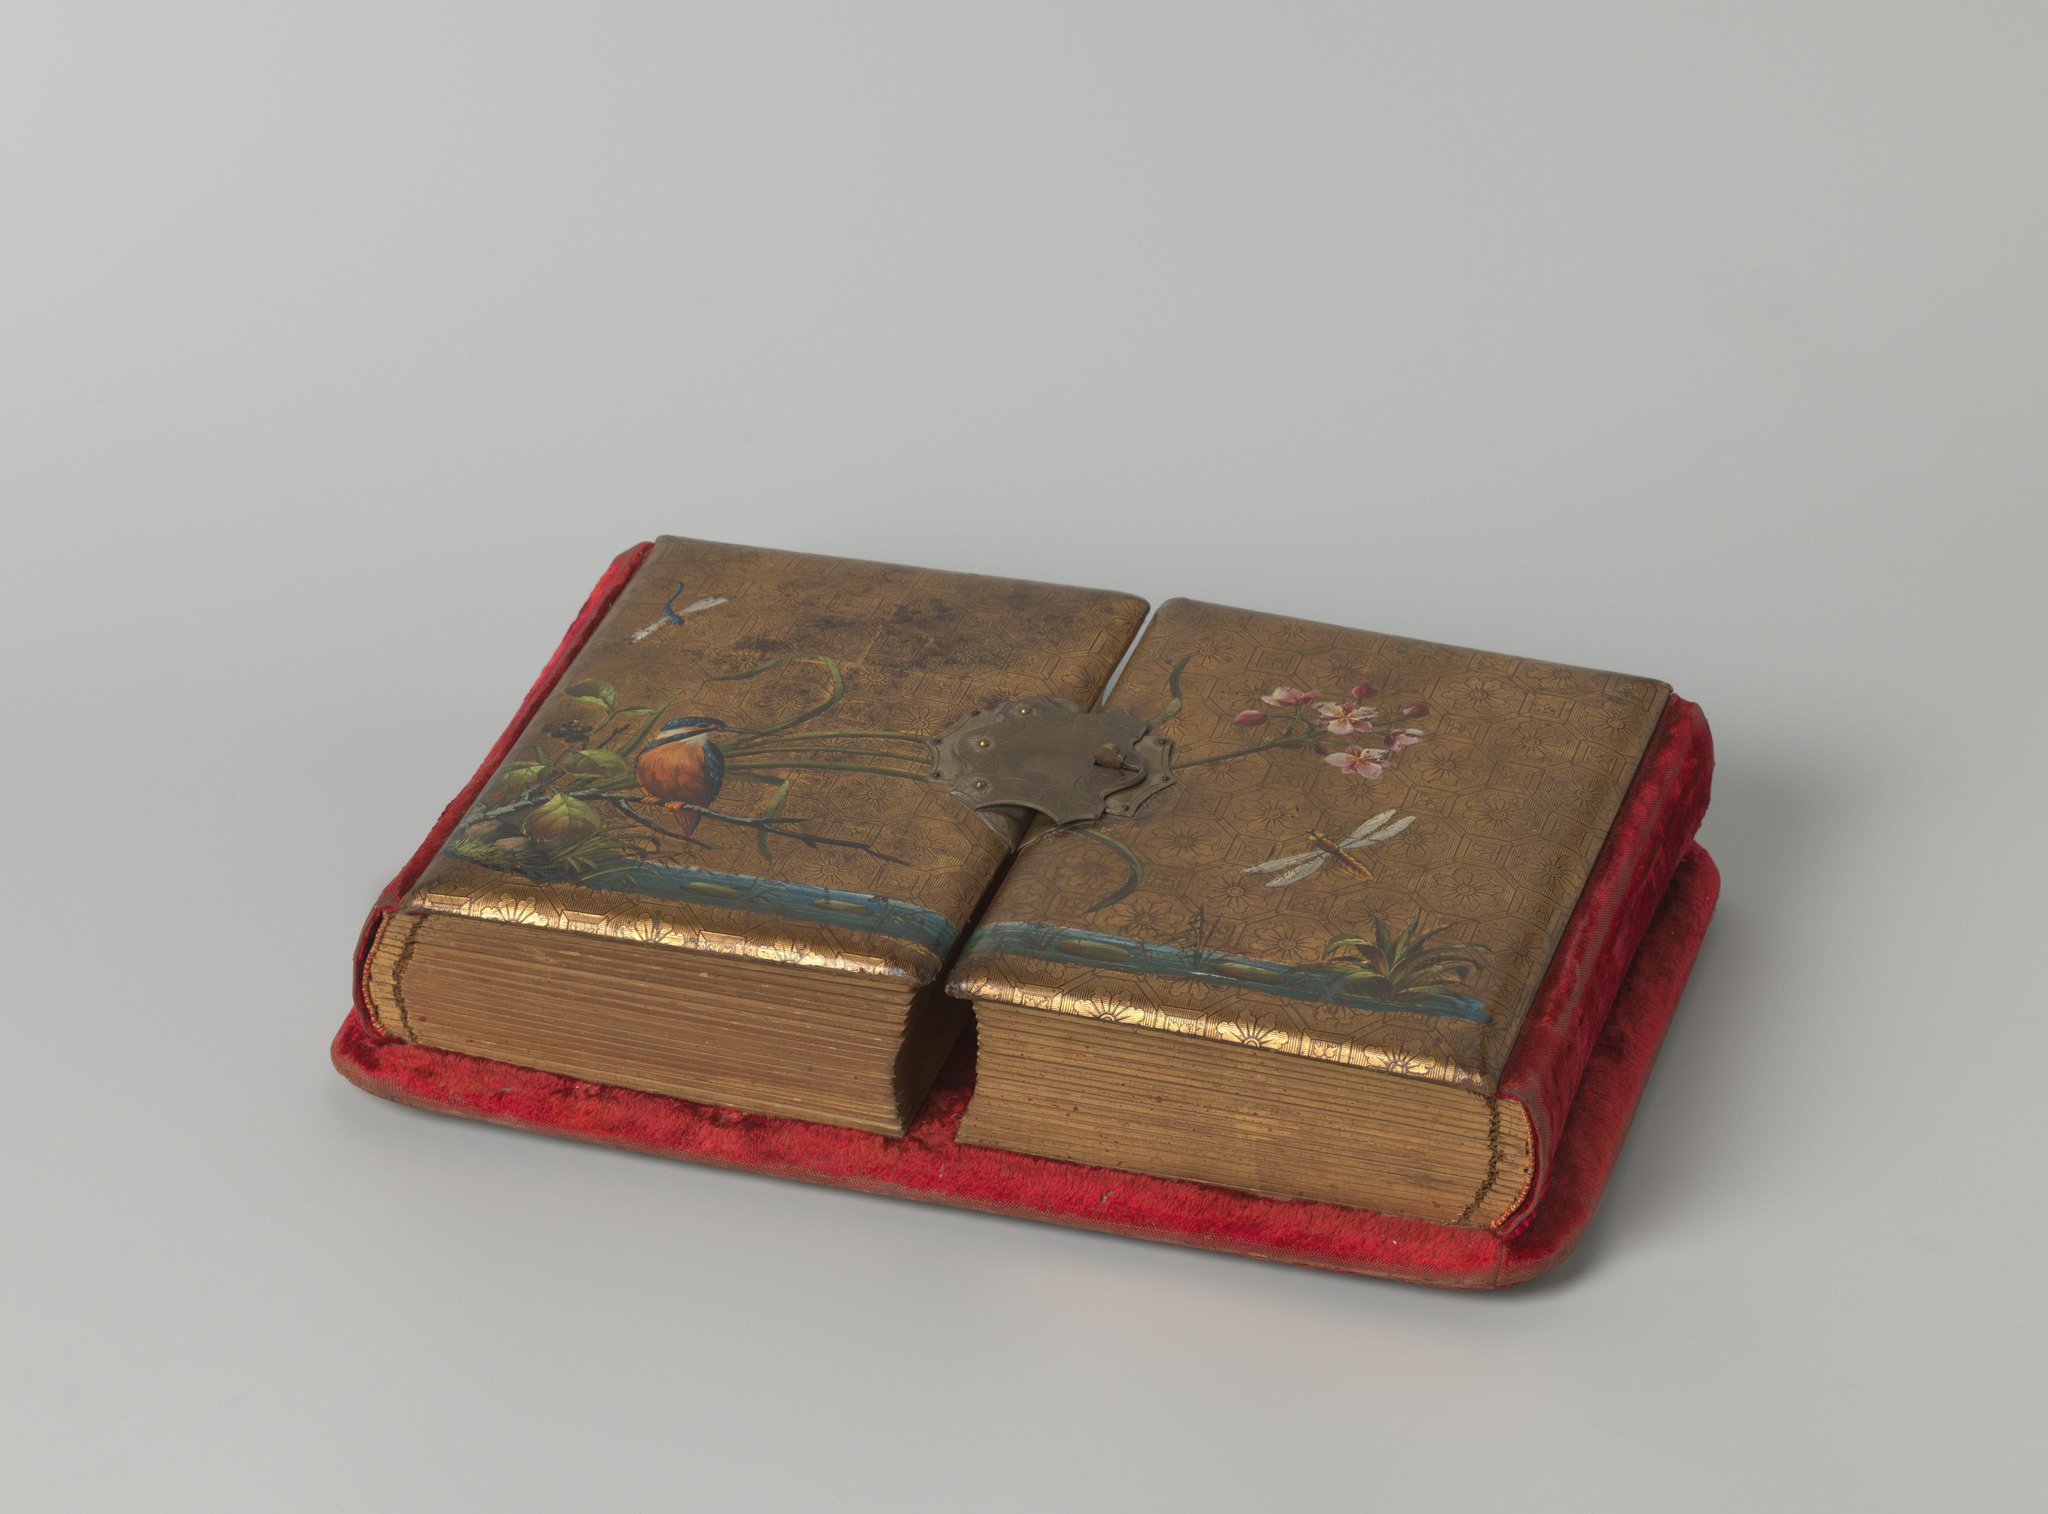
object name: slip in album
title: Portretten van artiesten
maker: Anonymous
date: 1860-1900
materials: cardboard, paint, leather, metal, photographic support, velvet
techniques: albumen print, brush, decorated paper, hand coloring, platinum process, woodburytype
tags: adult man, historical persons, portrait of actor, actress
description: Fotoalbum met 34 bladen en totaal 68 foto's, alle kabinetfoto's. Het album bevat portretten van verschillende artiesten.